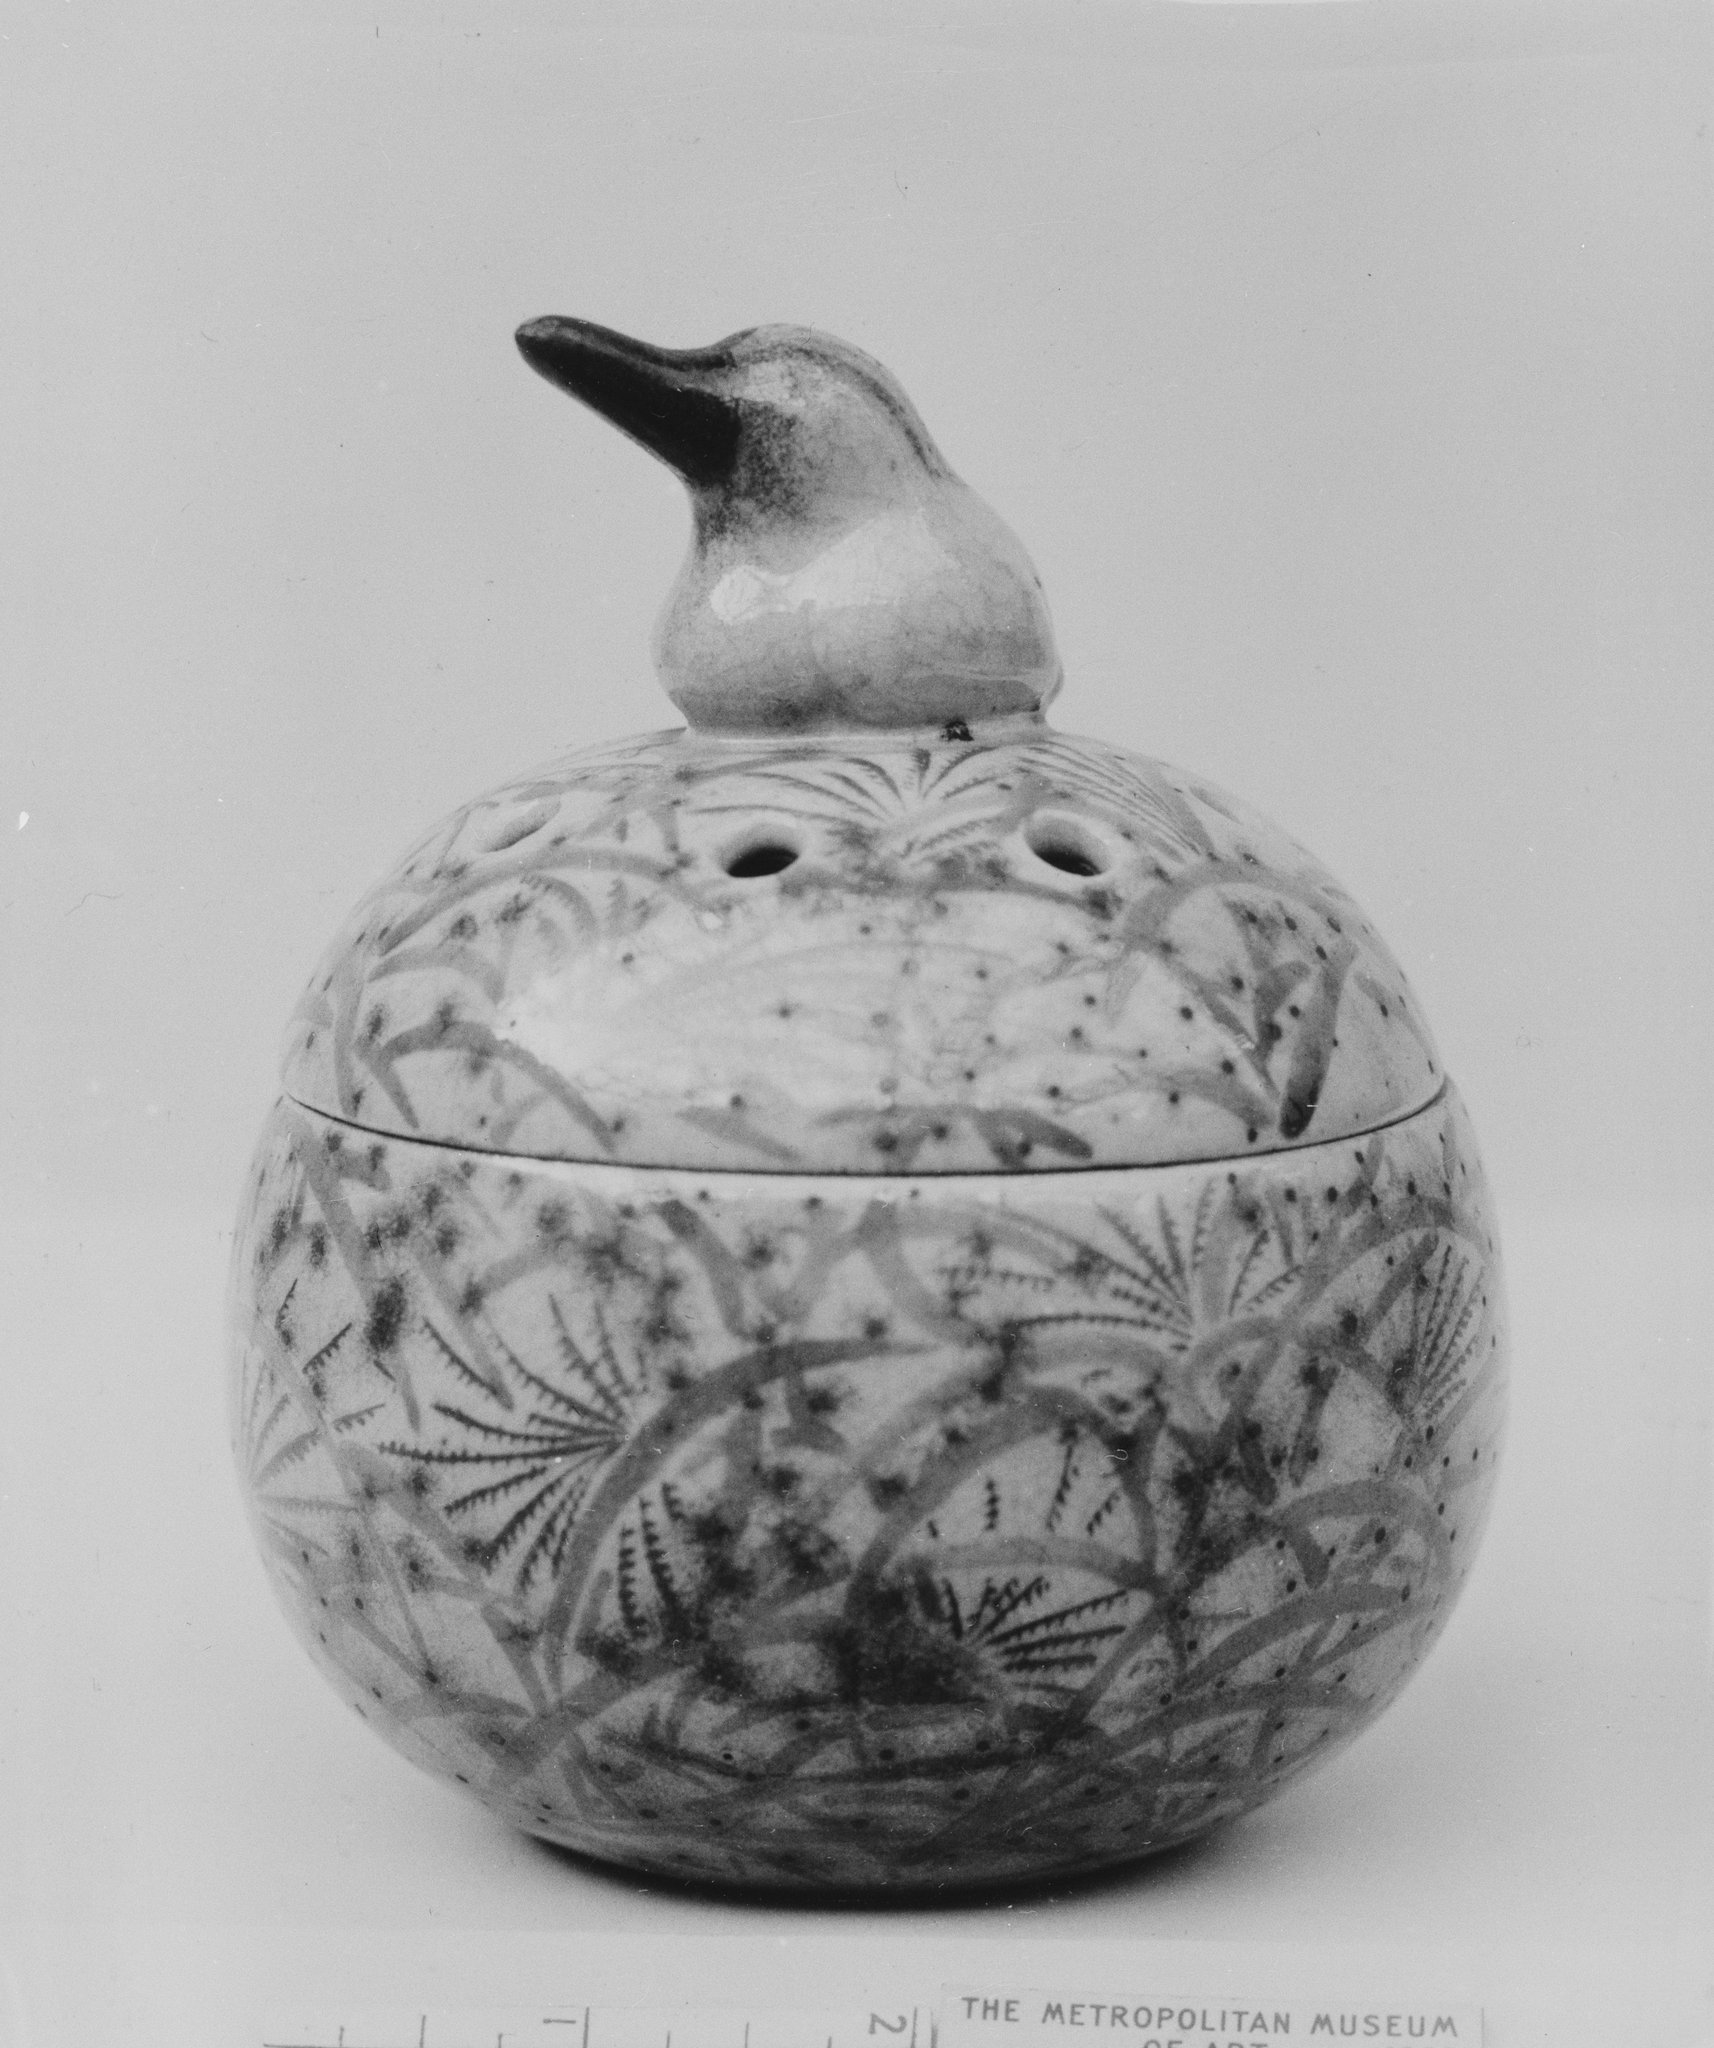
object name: censer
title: Censer with Kingfisher Knob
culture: japanese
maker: eiraku hozen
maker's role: artist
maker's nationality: japanese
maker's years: 1795-1854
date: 1820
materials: enamel, faience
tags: birds,censers